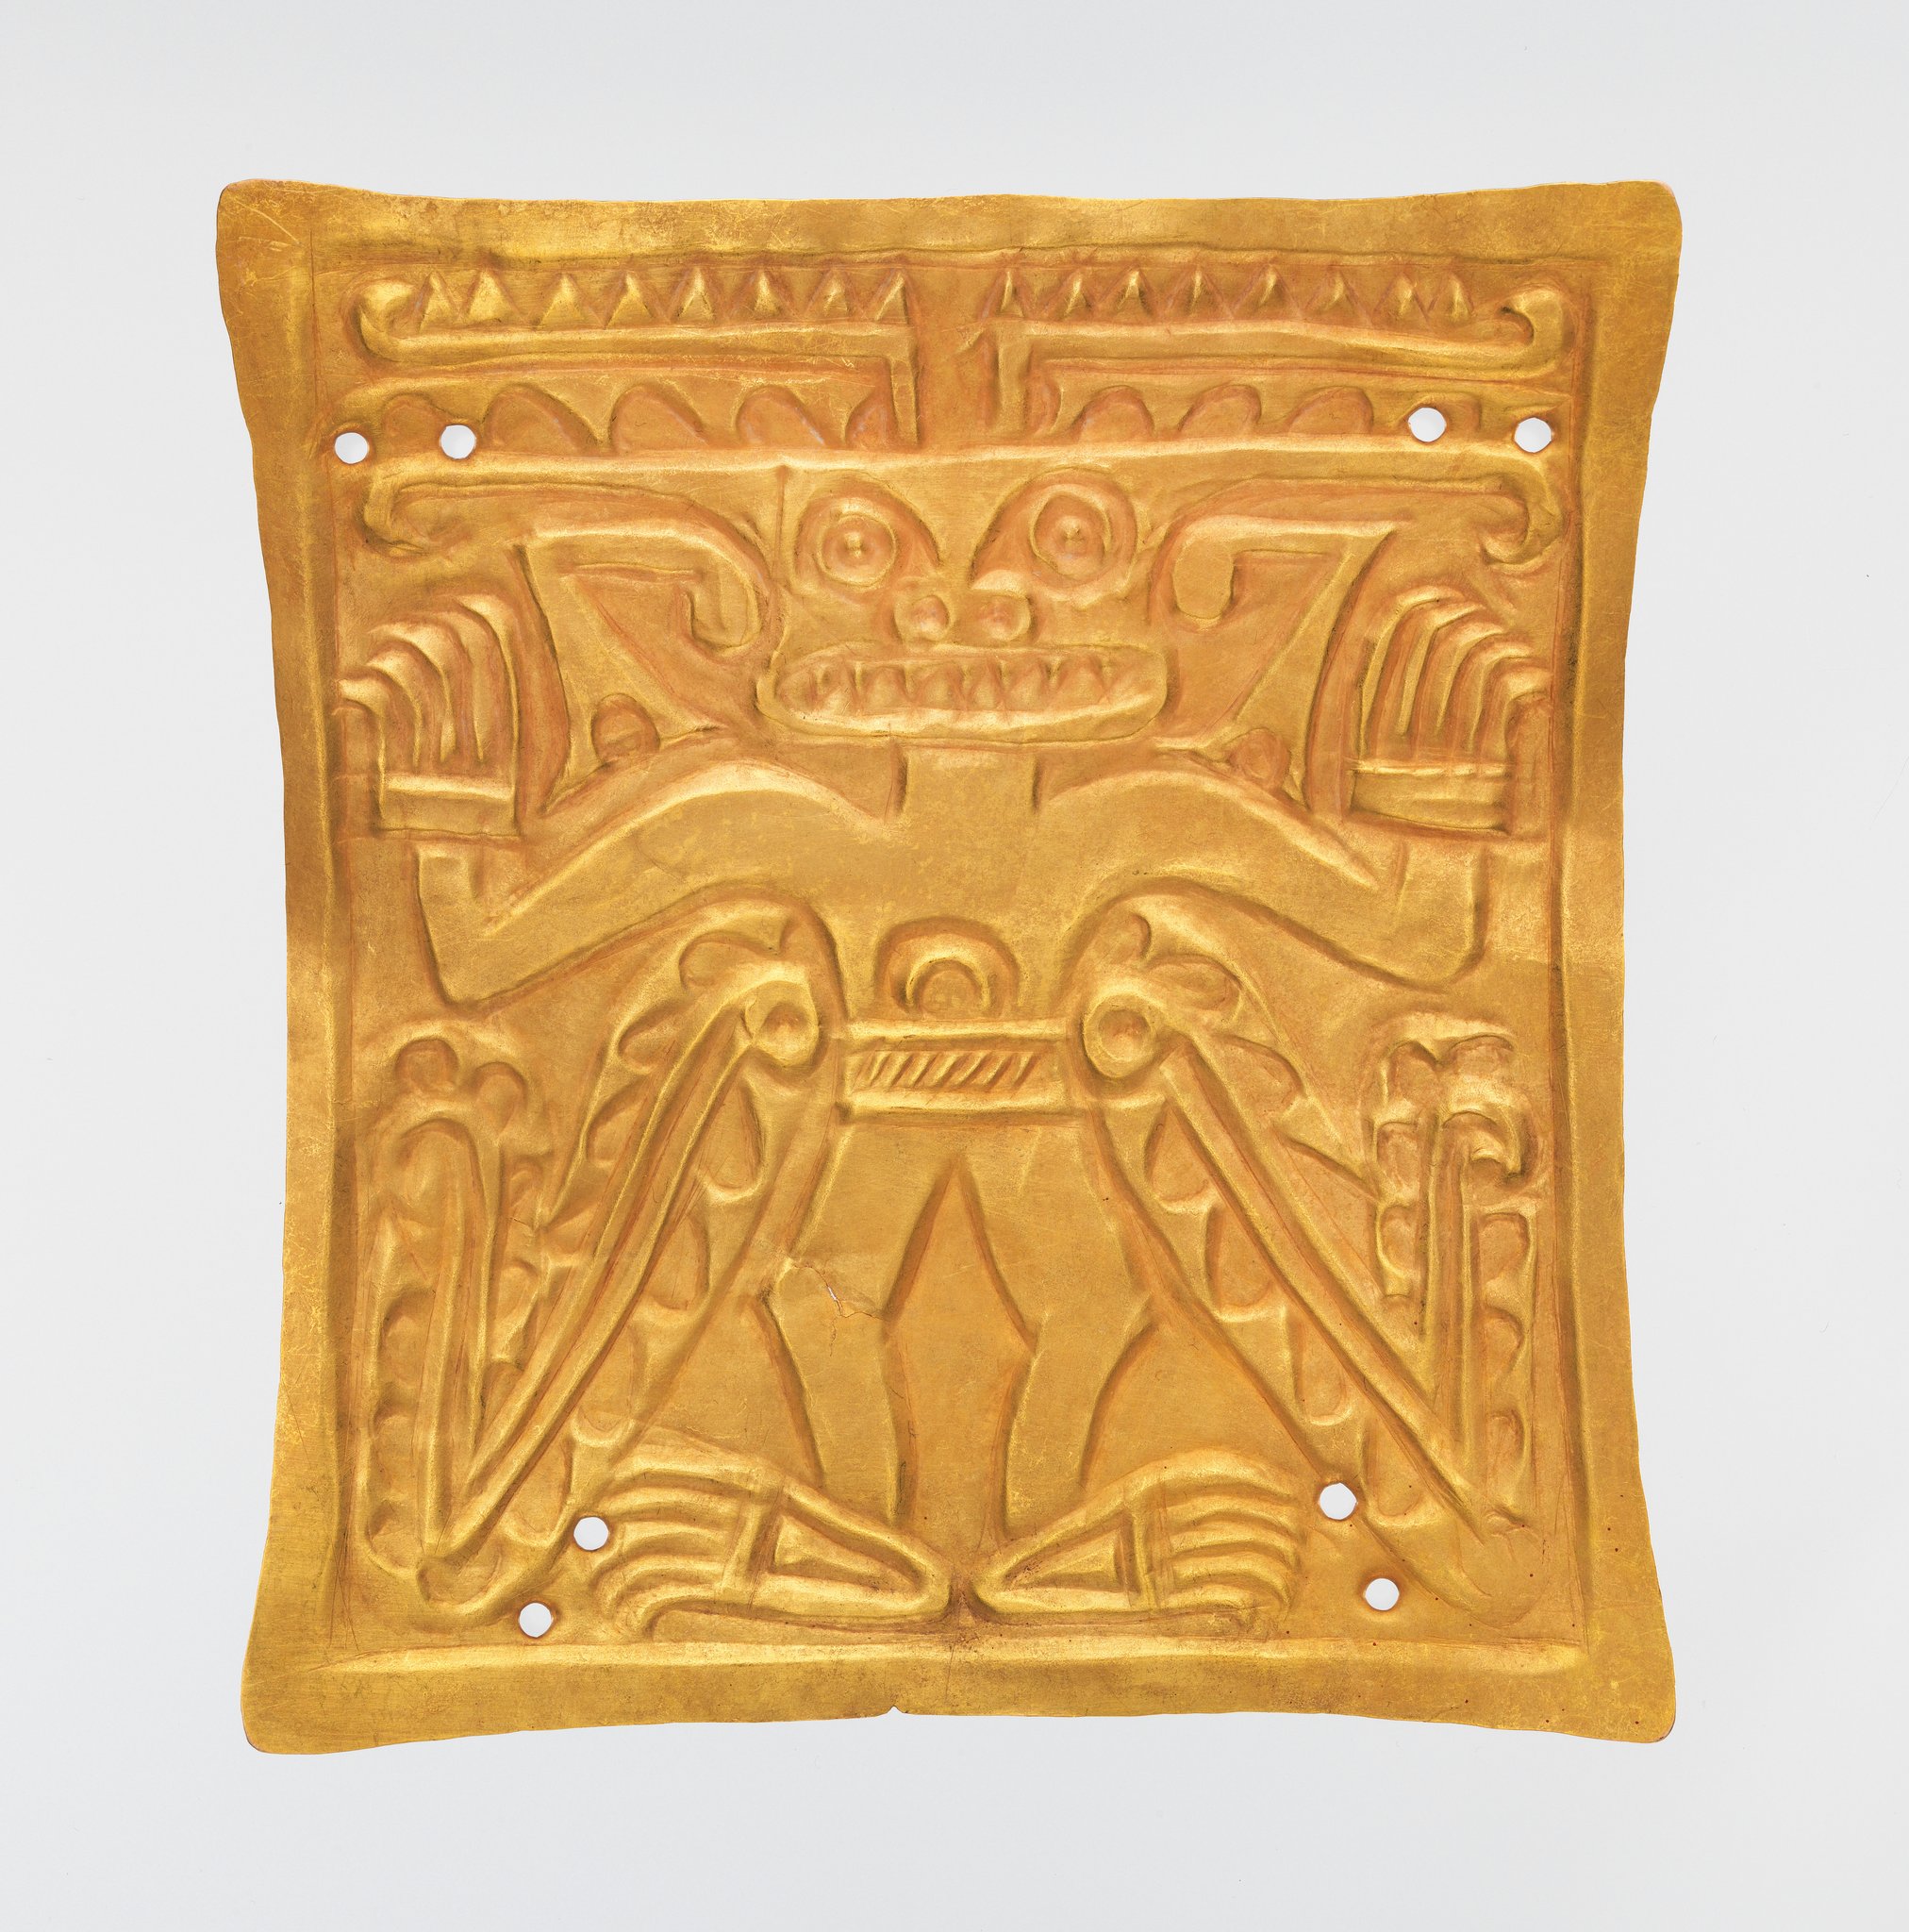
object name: plaque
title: Plaque with Masked Figure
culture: coclé, macaracas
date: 701-1200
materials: gold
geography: panama